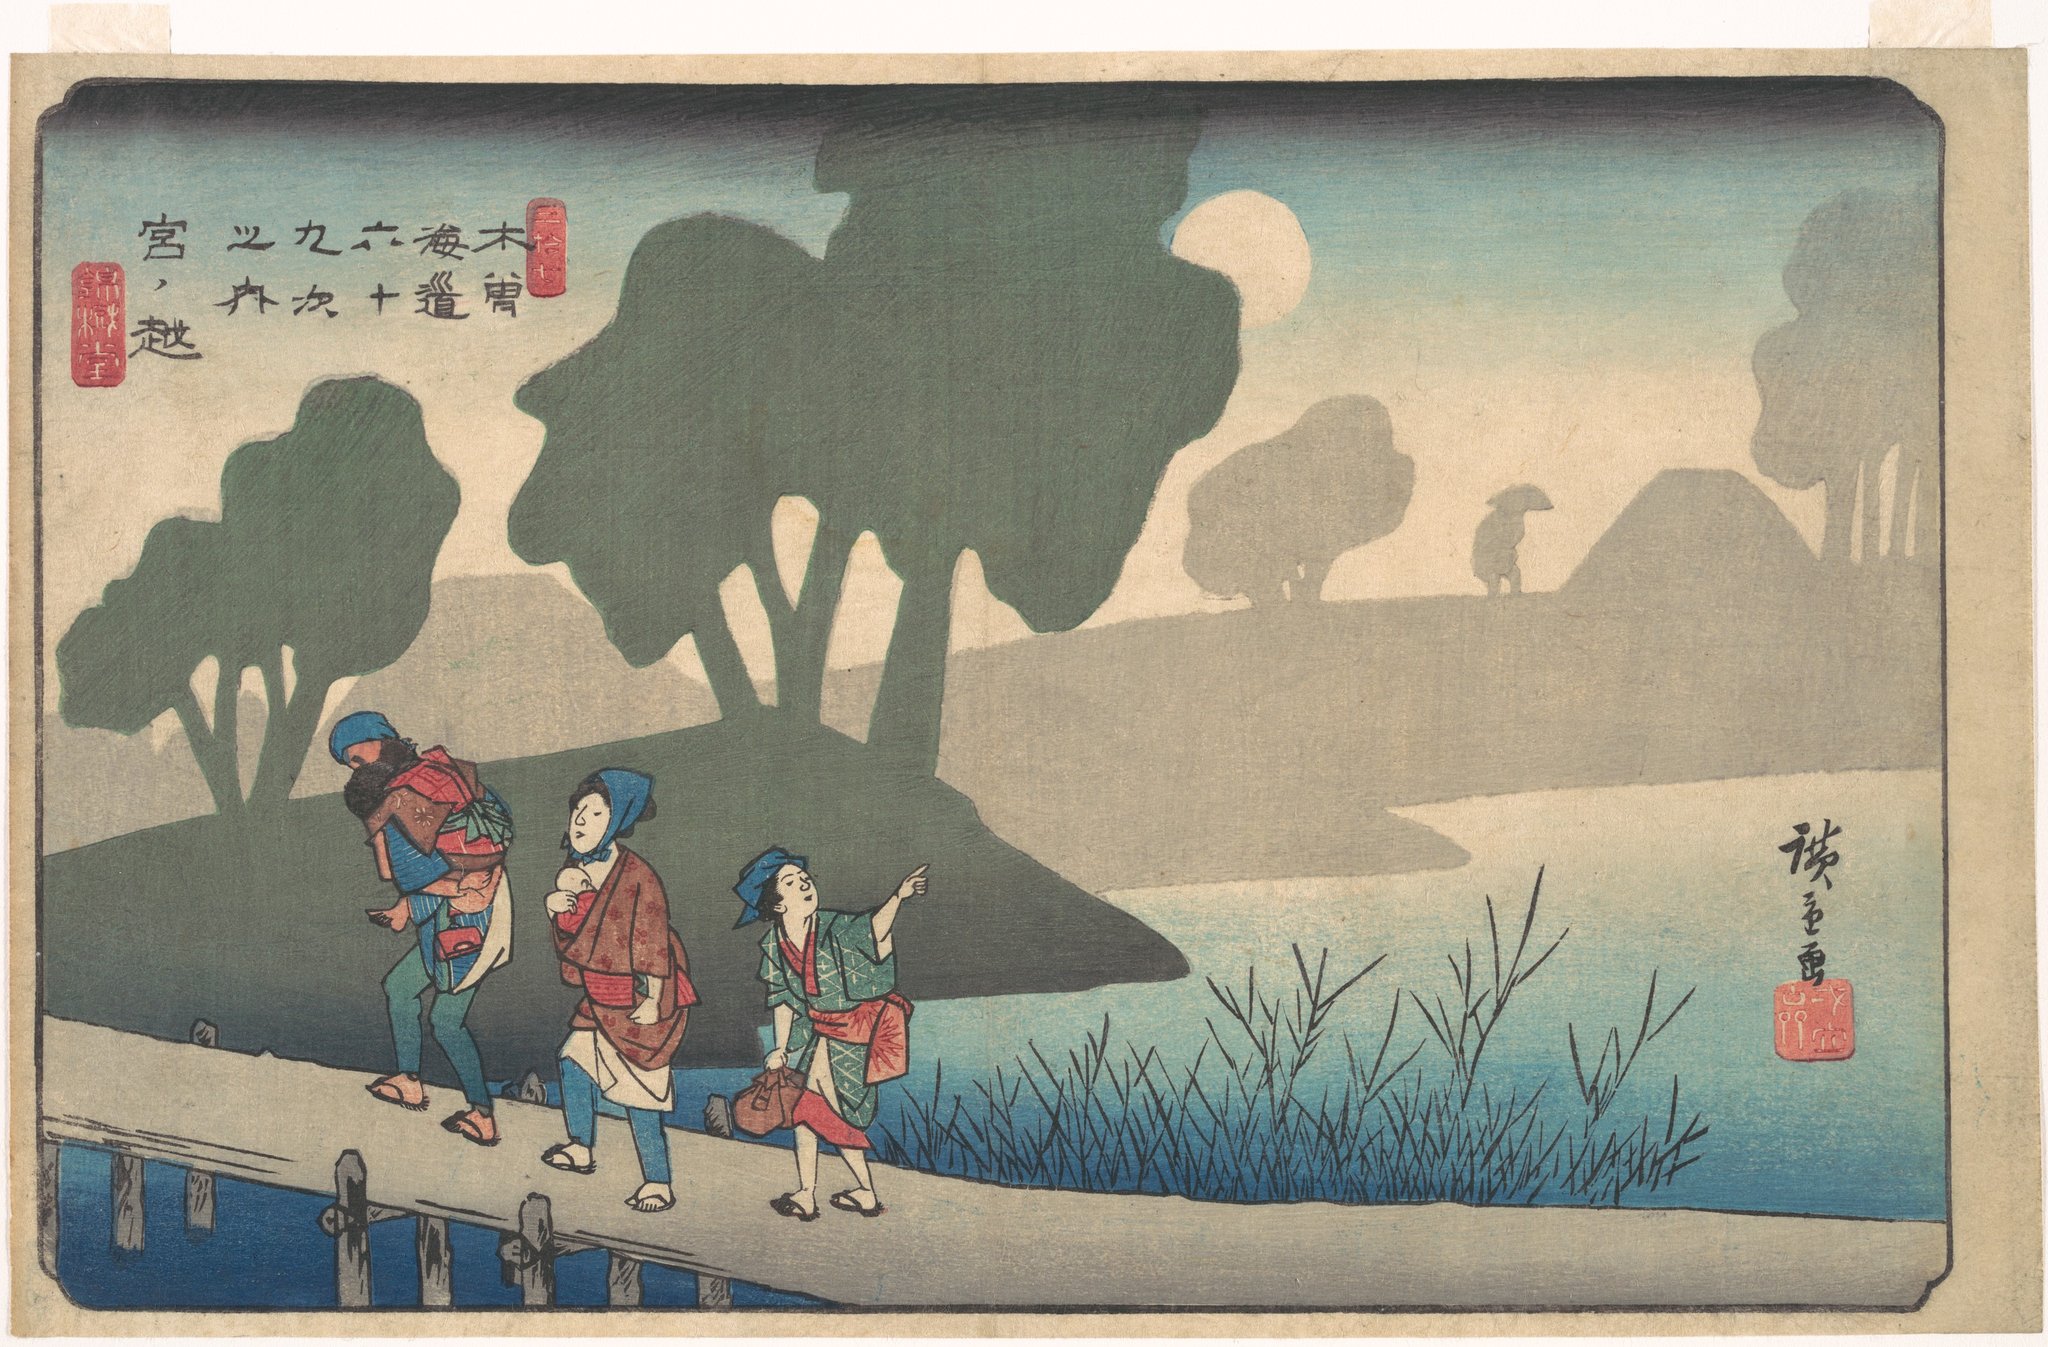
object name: print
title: Miyanokoshi Station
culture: japanese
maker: utagawa hiroshige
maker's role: artist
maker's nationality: japanese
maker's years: 1797-1858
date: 1836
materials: ink, paper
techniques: woodblock print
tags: human figures,bridges,trees